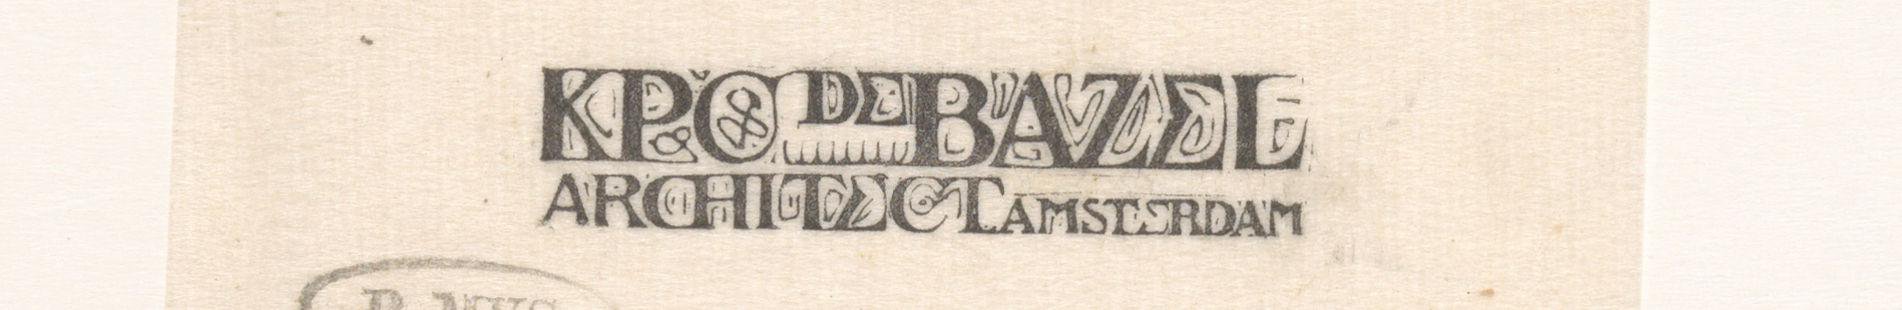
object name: print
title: Vignet K.P.C. de Bazel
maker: karel petrus cornelis de bazel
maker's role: draughtsman, print maker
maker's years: 1869-1923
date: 1895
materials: paper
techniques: woodcut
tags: den helder, amsterdam, print maker, draughtsman, karel petrus cornelis de bazel, vignette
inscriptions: collector's mark: Lugt 2228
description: Vignet van Karel de Bazel, architect te Amsterdam.